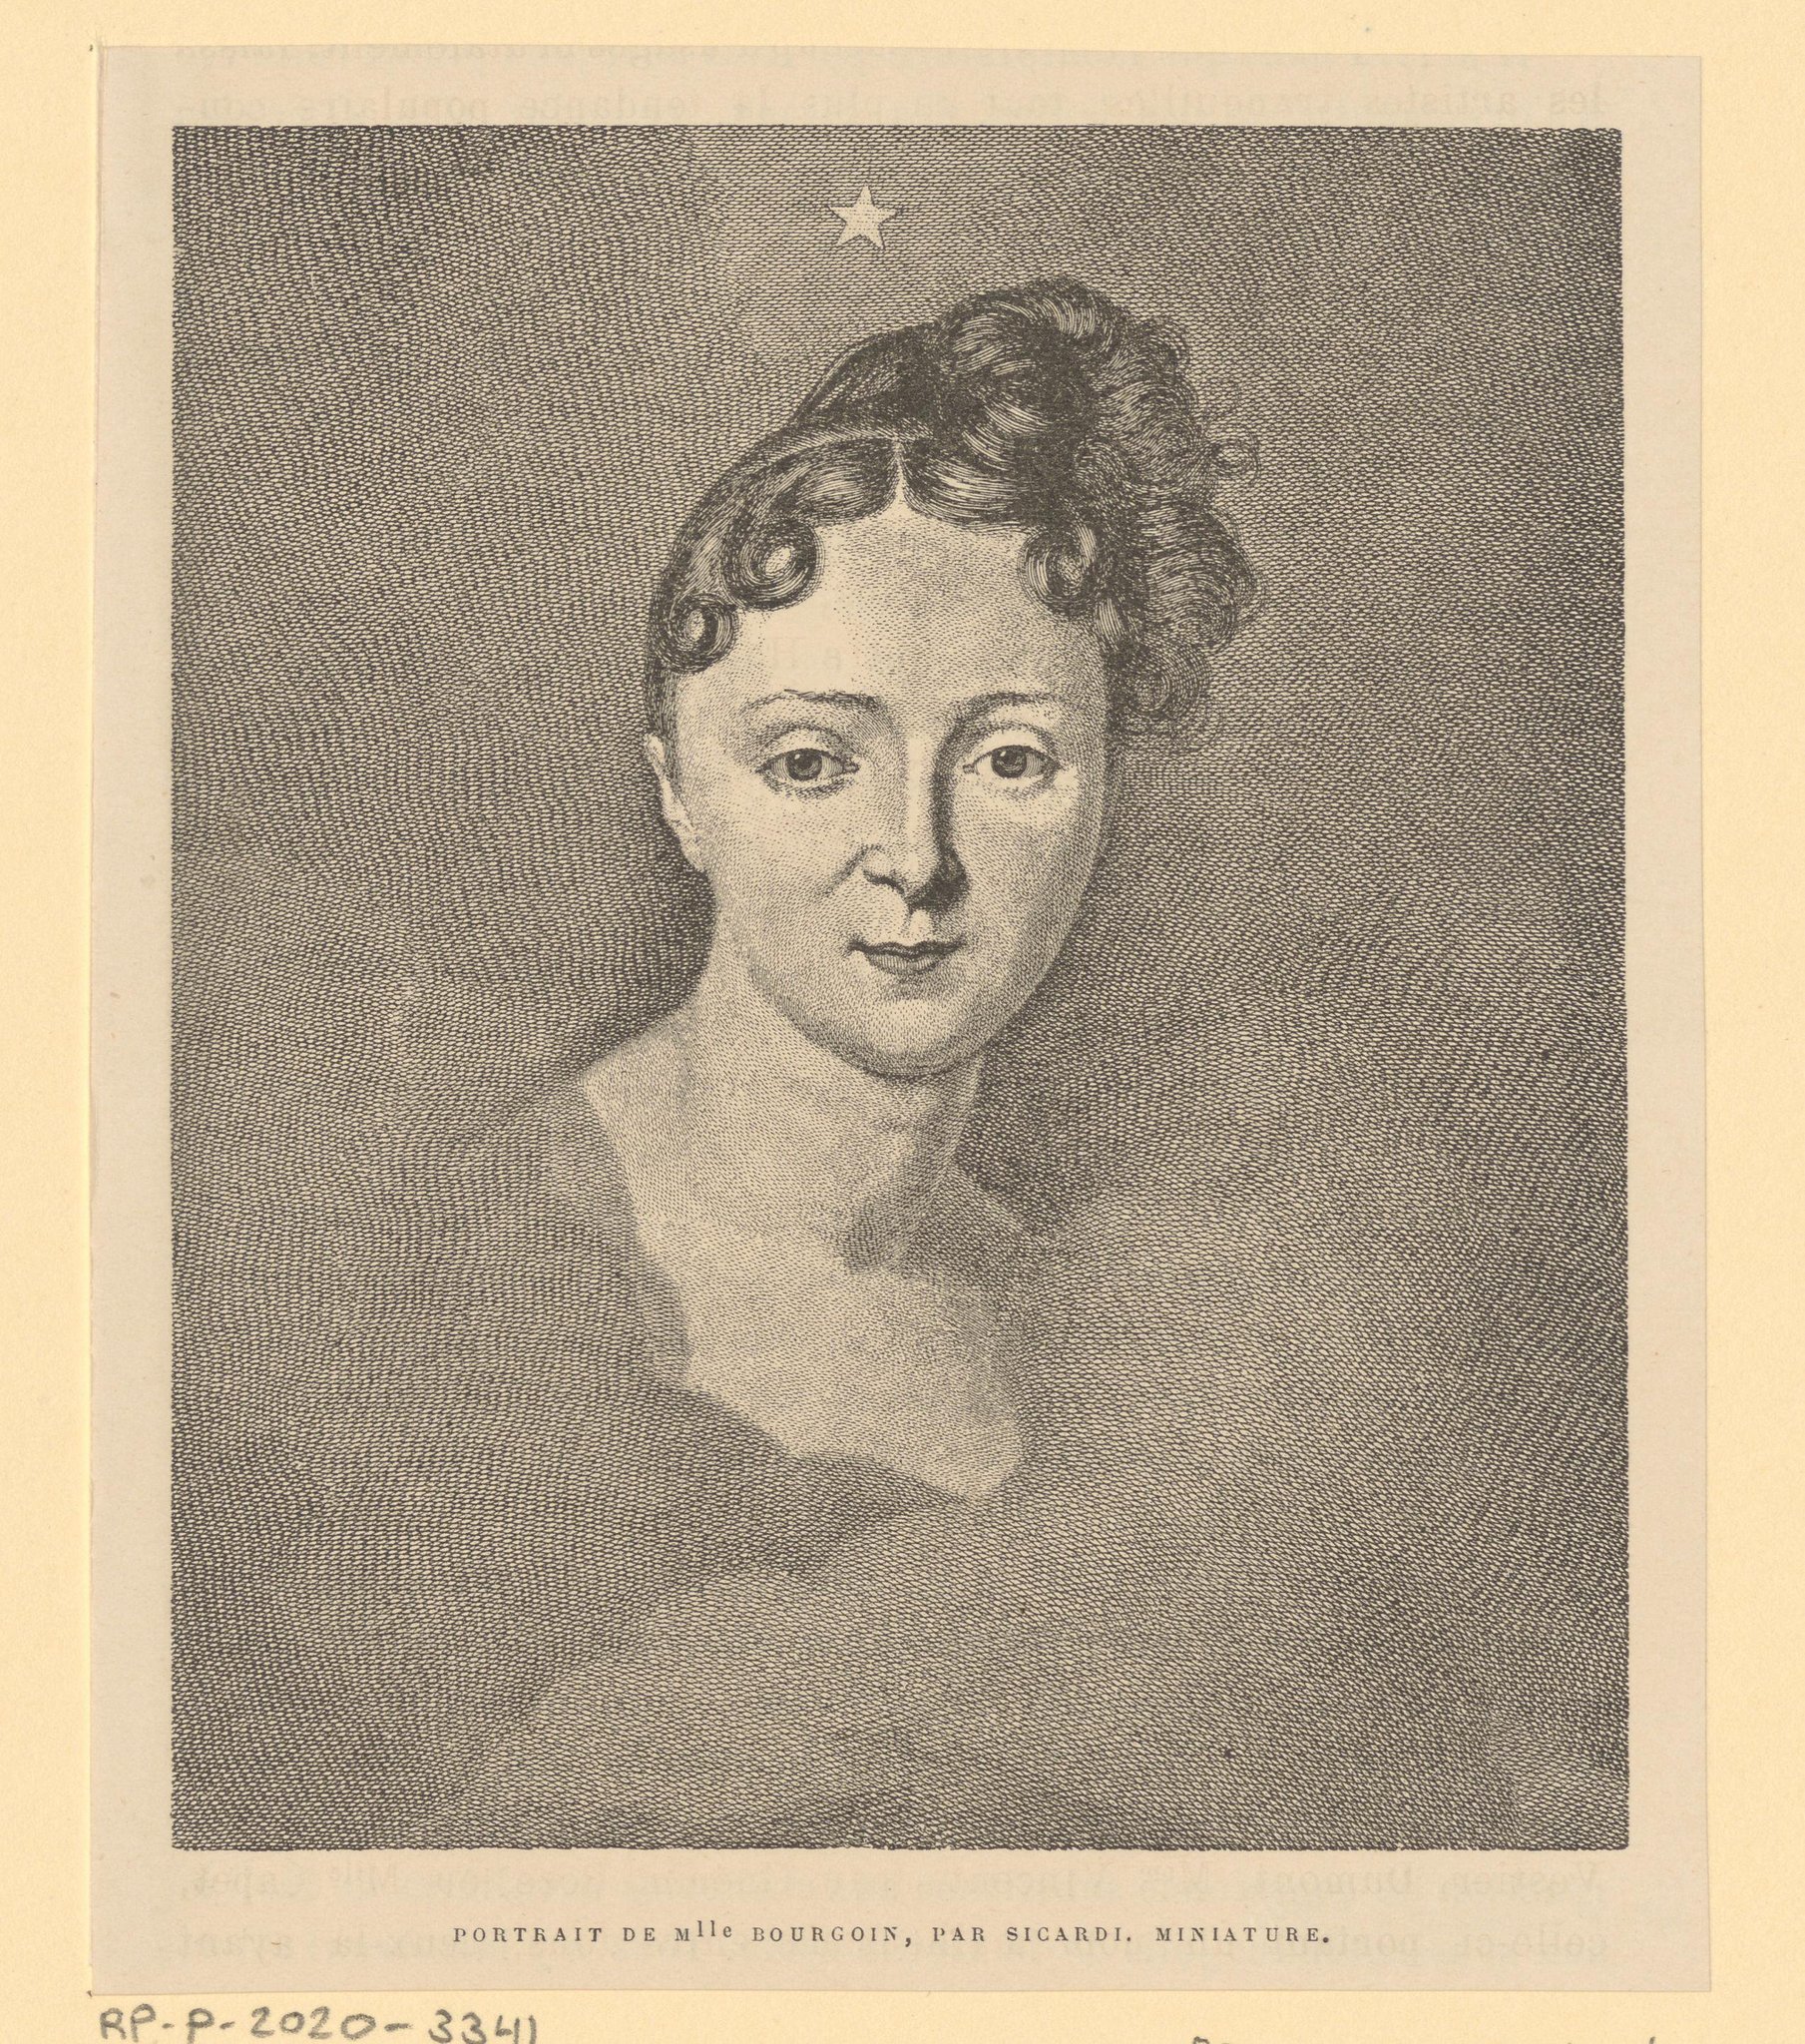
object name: photomechanical print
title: Portret van Marie-Thérèse-Étiennette Bourgoin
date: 1894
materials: paper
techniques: letterpress printing, printing block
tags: paris, historical persons - bb - woman, portrait of actor, actress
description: Prent uit: Gazette des beaux-arts, 1894.